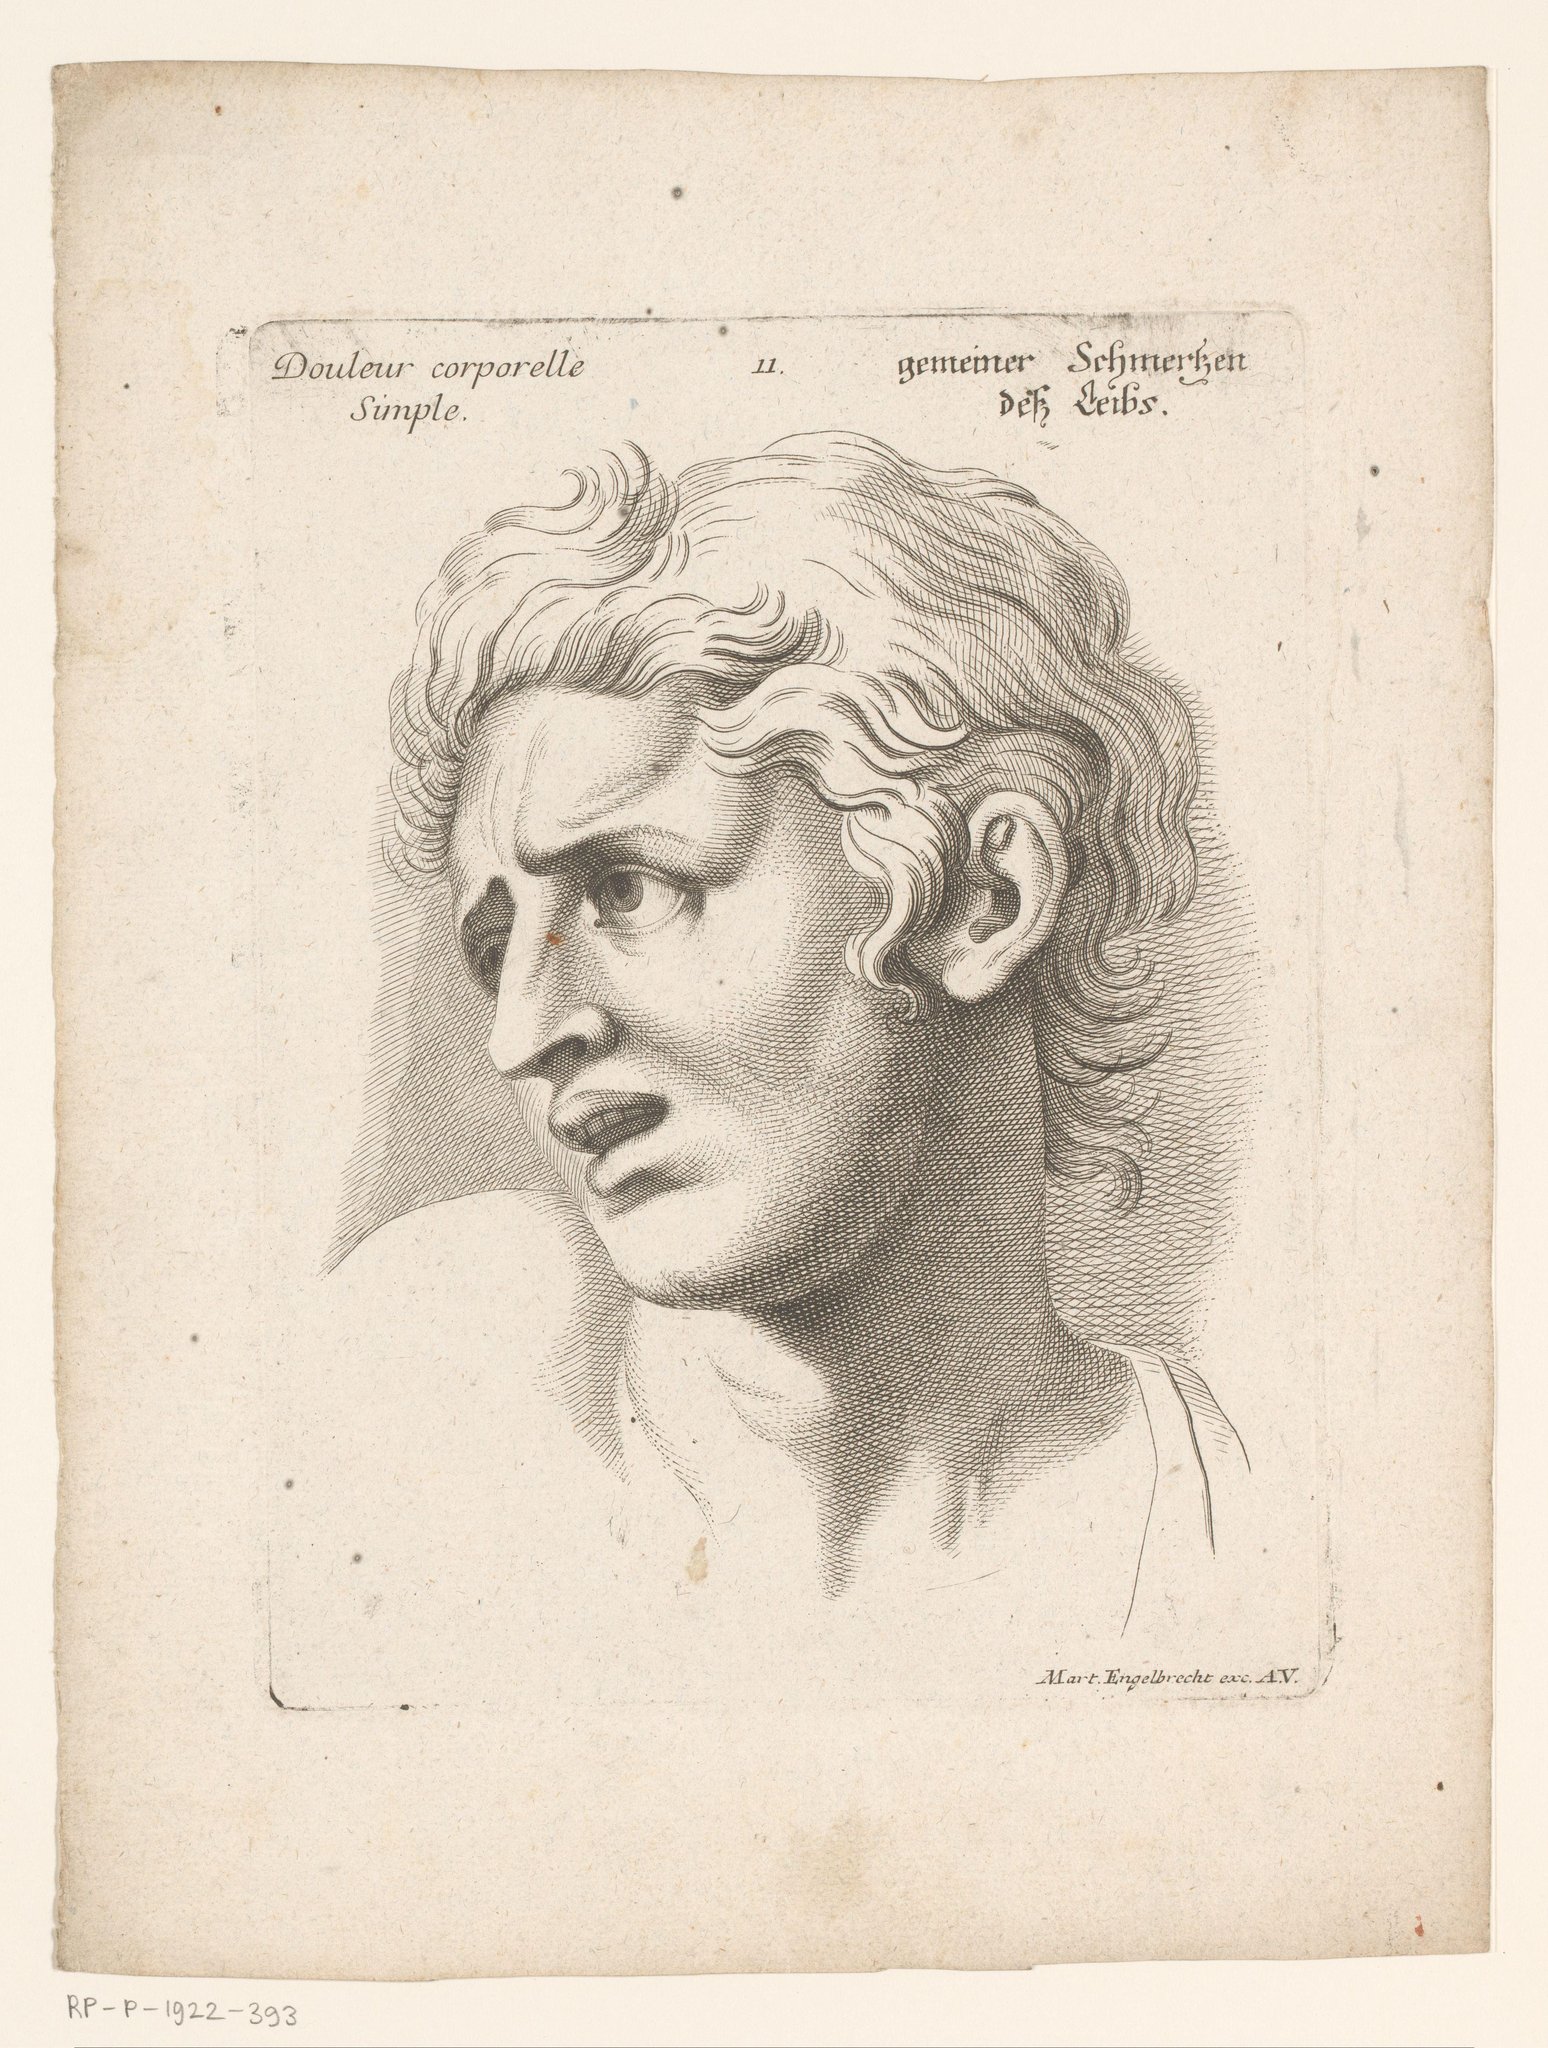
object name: print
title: Hoofd van een man in een staat van pijn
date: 1732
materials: paper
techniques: engraving, etching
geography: augsburg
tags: pain, sorrow, sadness; 'dolore', 'dolore di zeusi' (ripa), morphology of facial expression, physiognomy, pain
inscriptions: collector's mark: Lugt 2233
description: Prent uit een serie met hoofden met verschillende uitdrukkingen naar Charles Le Brun, uitgegeven door Martin Engelbrecht in 1732.